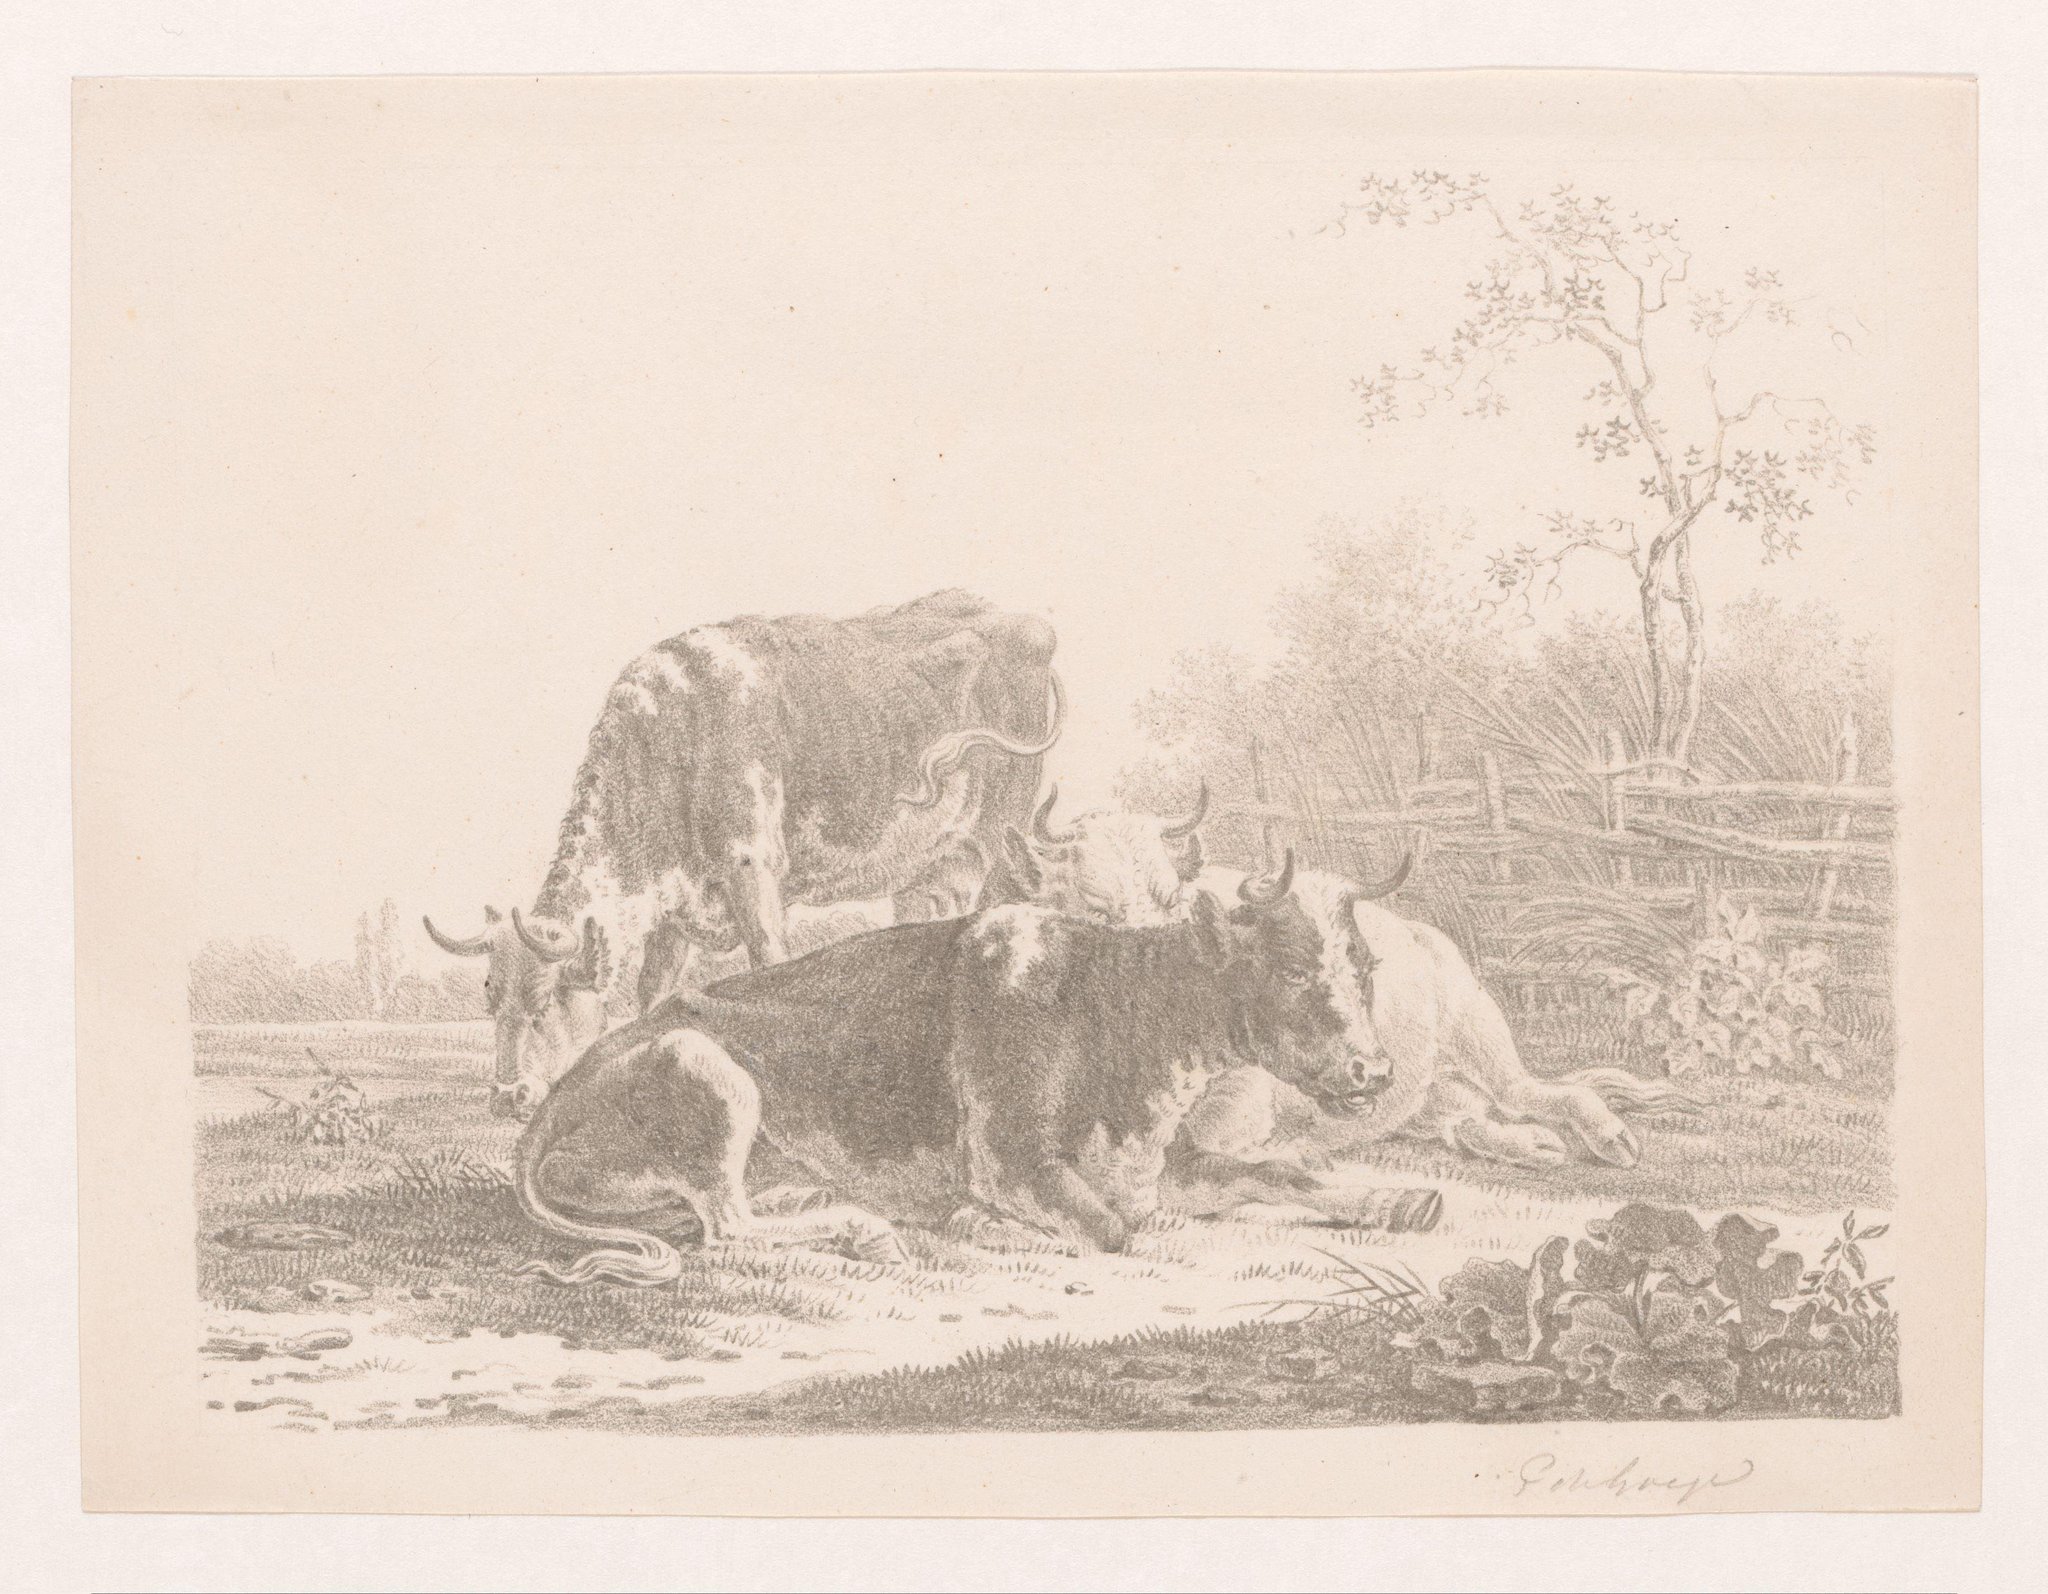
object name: drawing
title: Drie koeien in een weide bij een hek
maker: pieter de goeje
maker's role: draughtsman, print maker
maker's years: 1789-1859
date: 1809-1859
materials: chalk, paper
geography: netherlands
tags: cow, fence, wall, paling, meadow, pasture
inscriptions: collector's mark: Lugt 2228